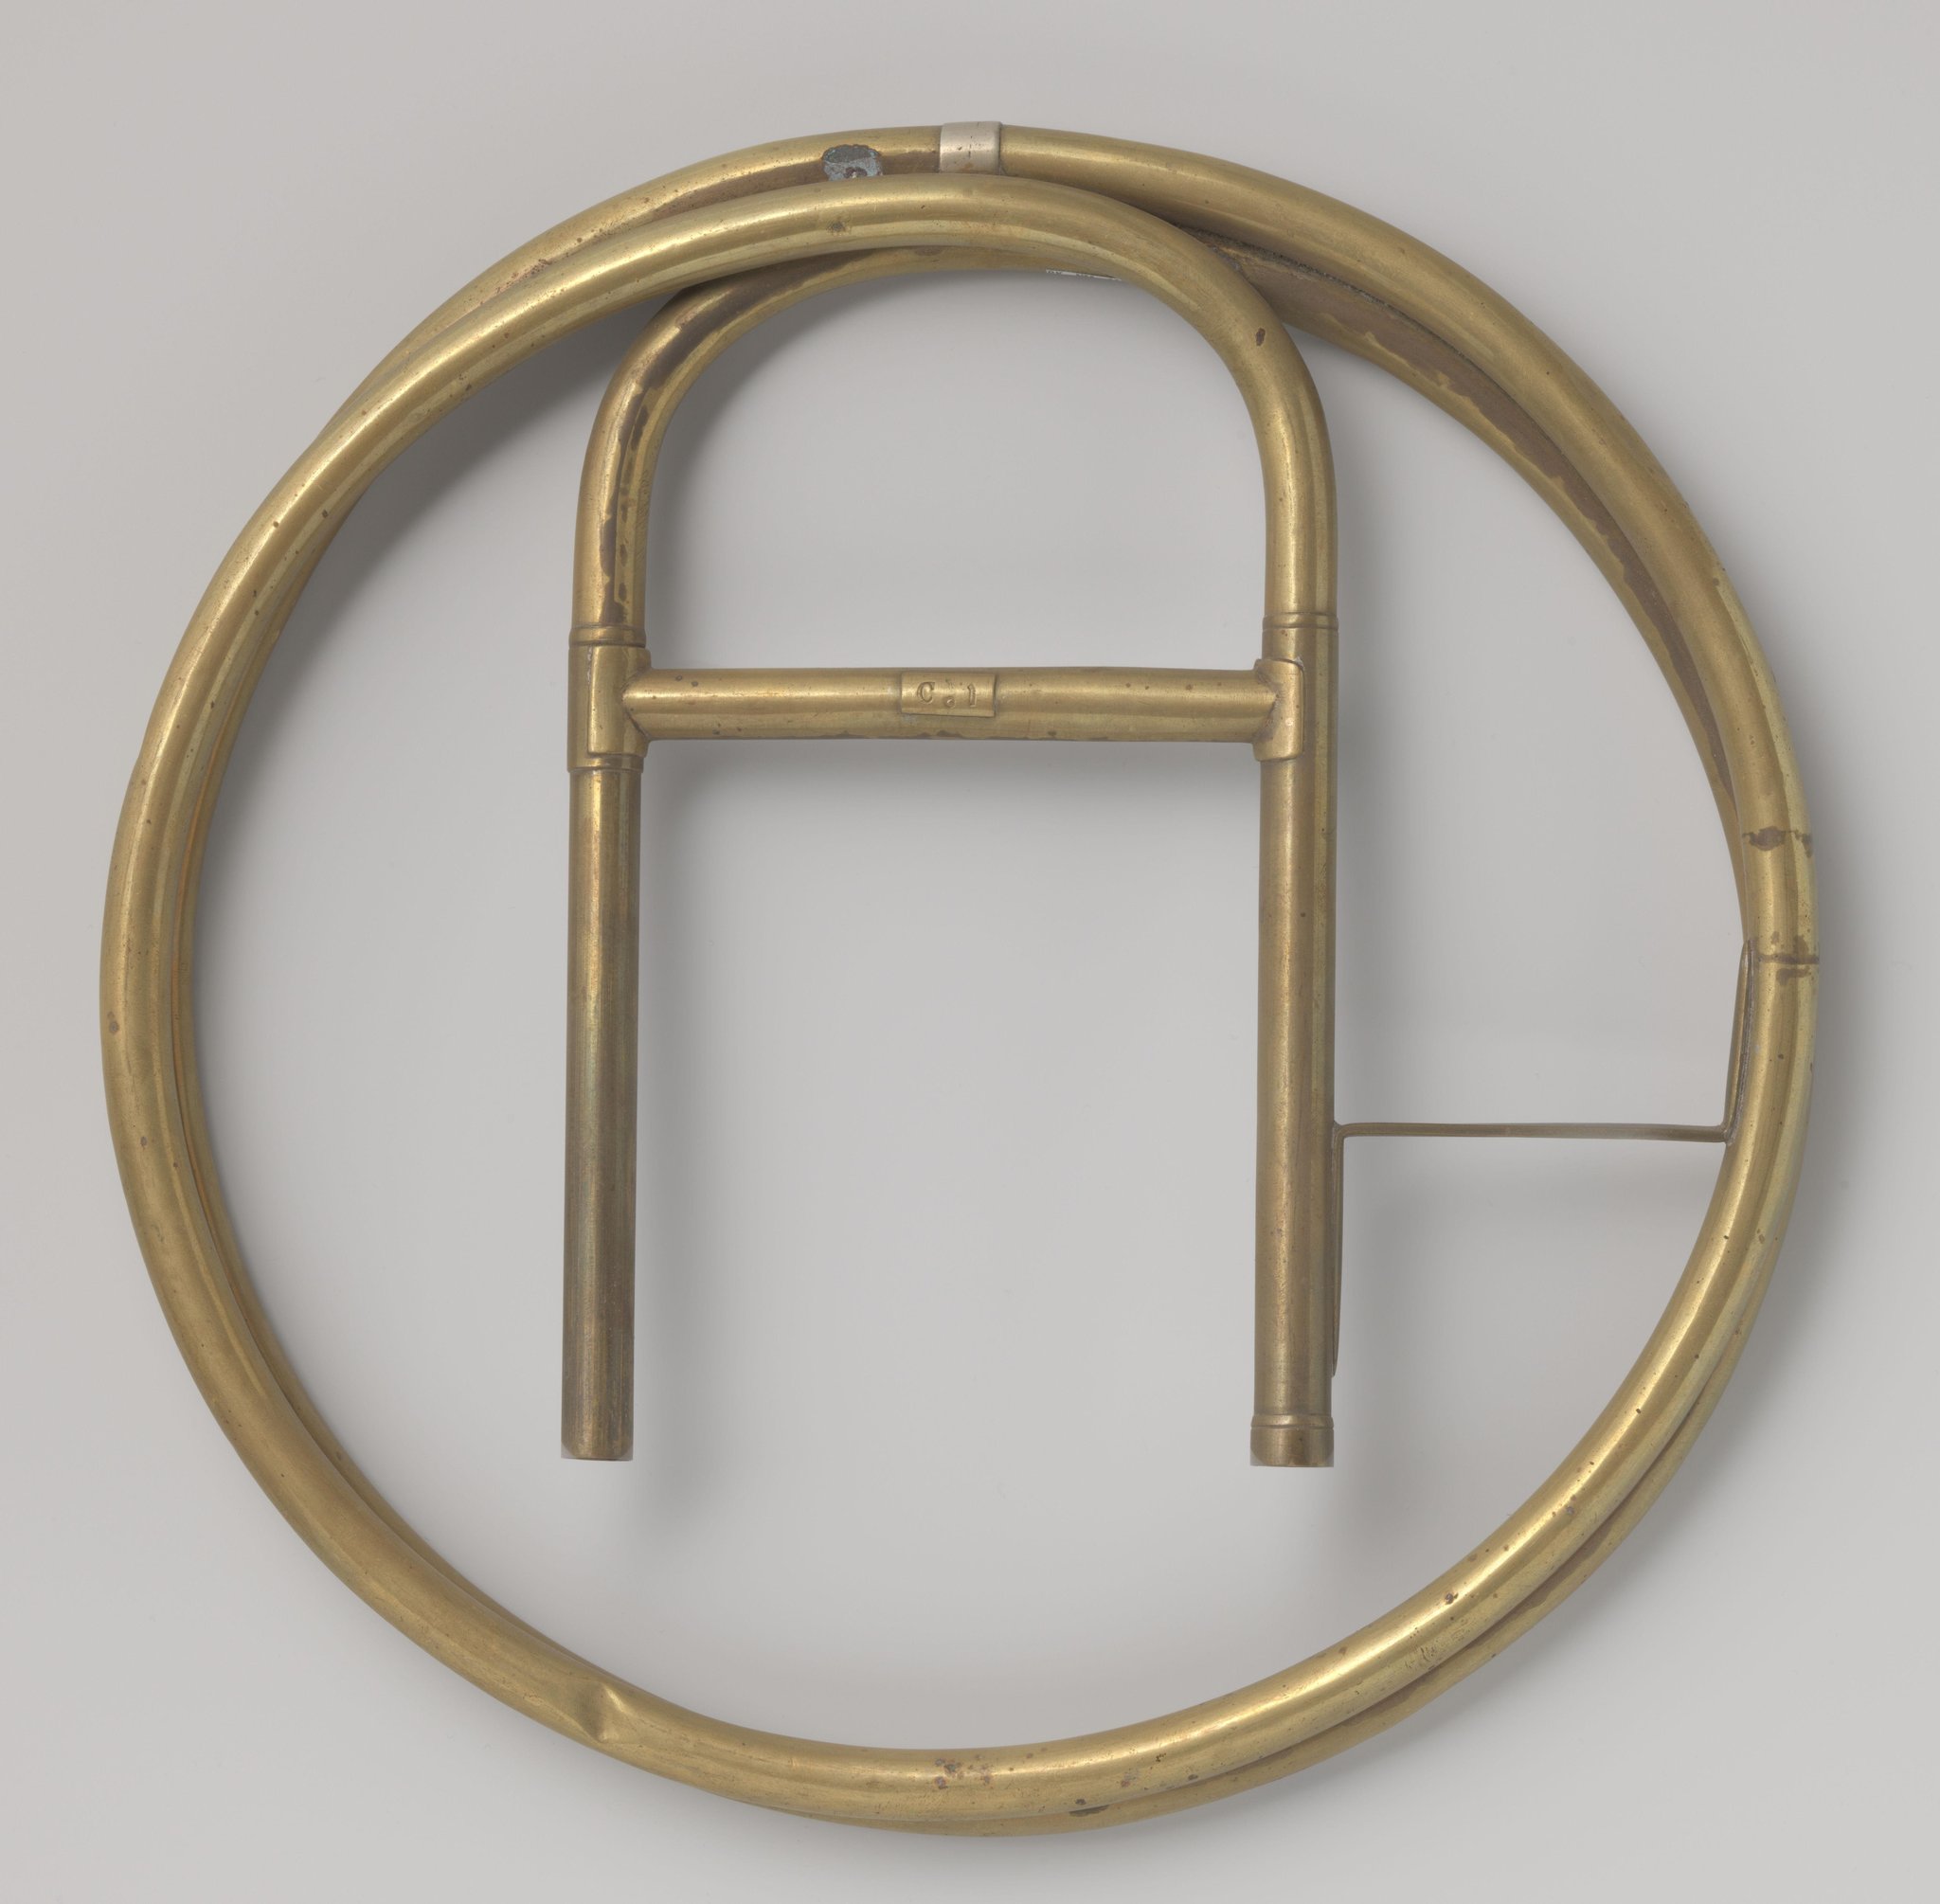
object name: horn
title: Invention horn crook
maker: carl gottlob schüster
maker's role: instrument maker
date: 1850-1950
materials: copper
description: Beugel van inventionshoorn. Gemerkt: C.1